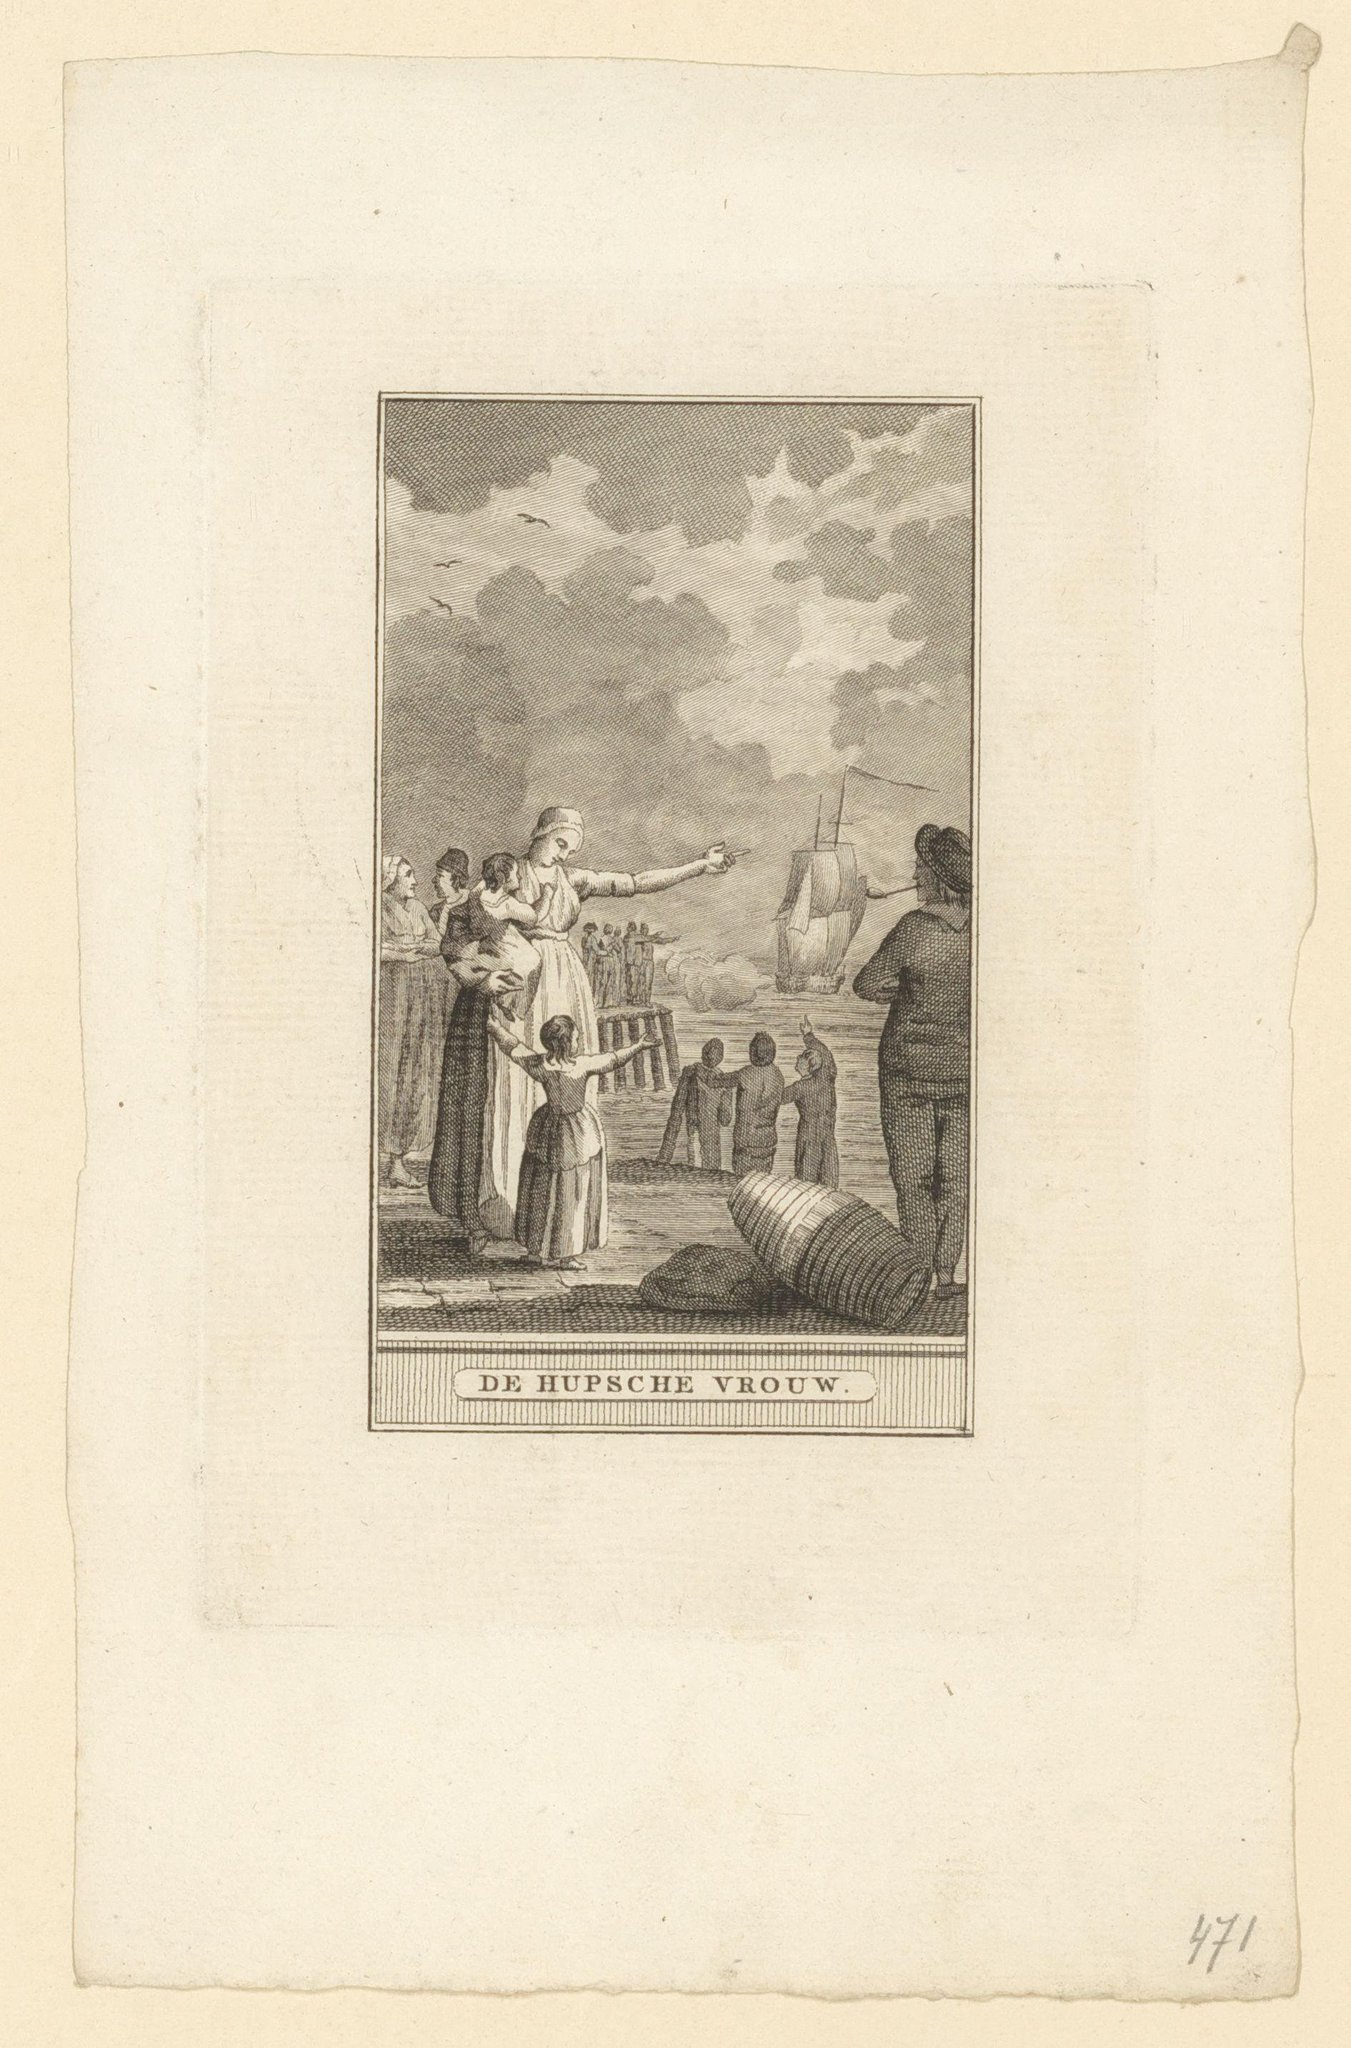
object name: print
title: Vrouw met kind op haar arm wijst naar een uitvarend schip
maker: Anonymous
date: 1792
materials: paper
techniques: etching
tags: harbour, sailing-ship, sailing-boat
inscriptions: collector's mark: Lugt 1641, stamp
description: Prent waarschijnlijk uit: Wolff, Betje. Economische liedjes: met plaaten. Den Haag: Isaac van Cleef, 1792.